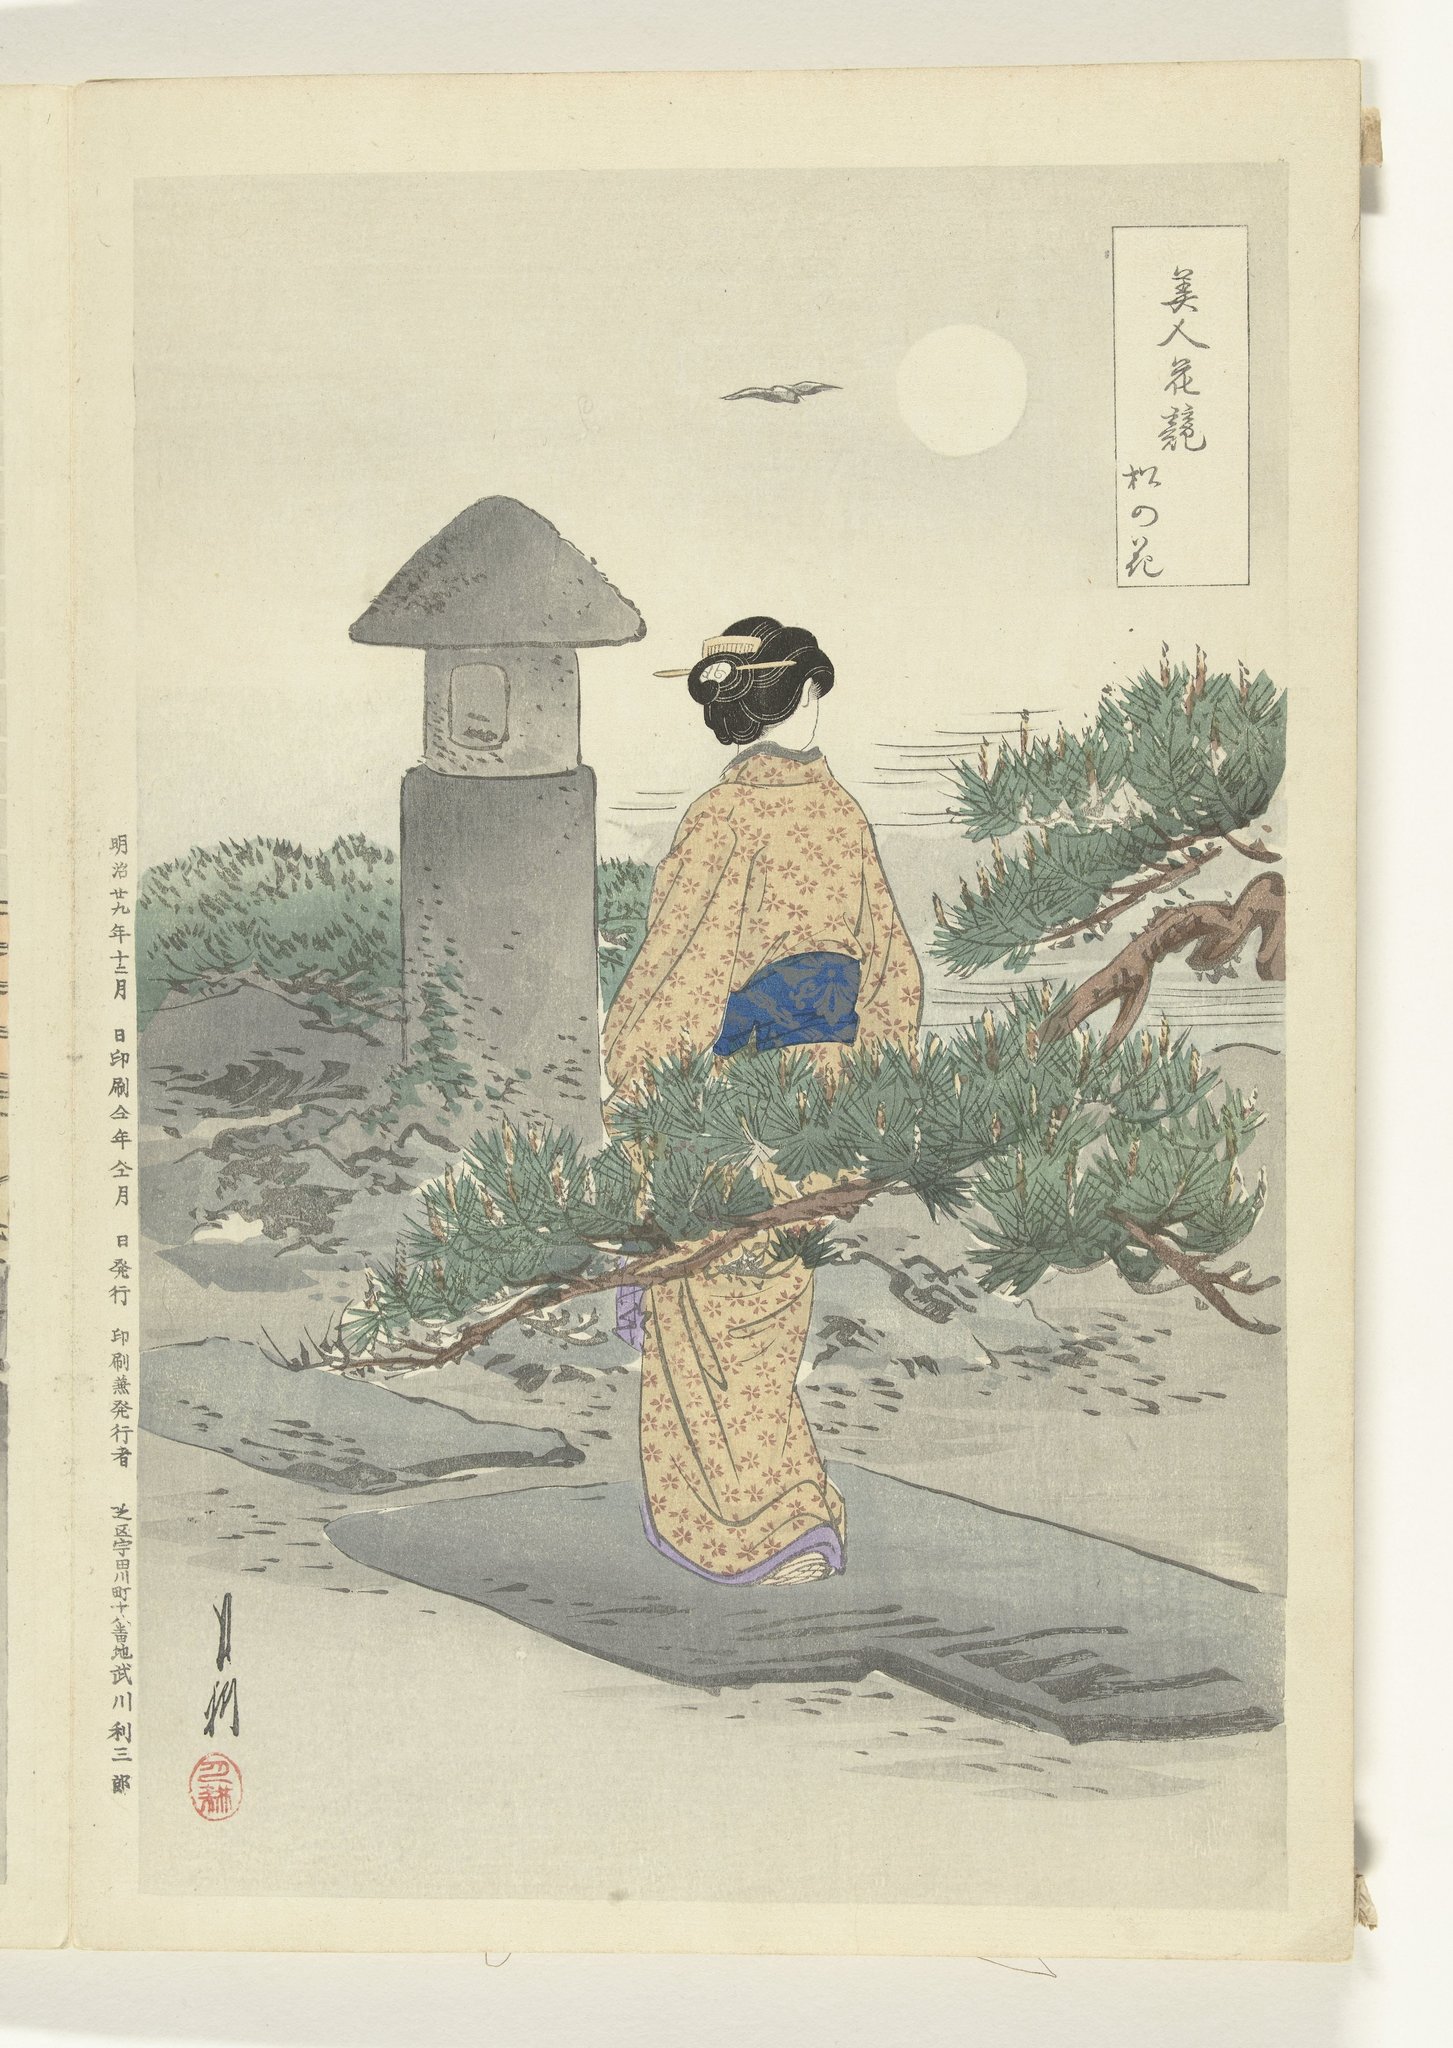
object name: print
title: Vergelijkingen tussen schoonheden en bloemen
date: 1810-1896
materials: paper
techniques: blind stamped, woodcut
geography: japan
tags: landscapes (+ landscape with figures, staffage), trees: pine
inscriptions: collector's mark: Lugt 2228, collector's mark: Lugt 2760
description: Vrouw, op de rug gezien, lopend bij pijnboom en stenen lantaarn, kijkend naar volle maan.